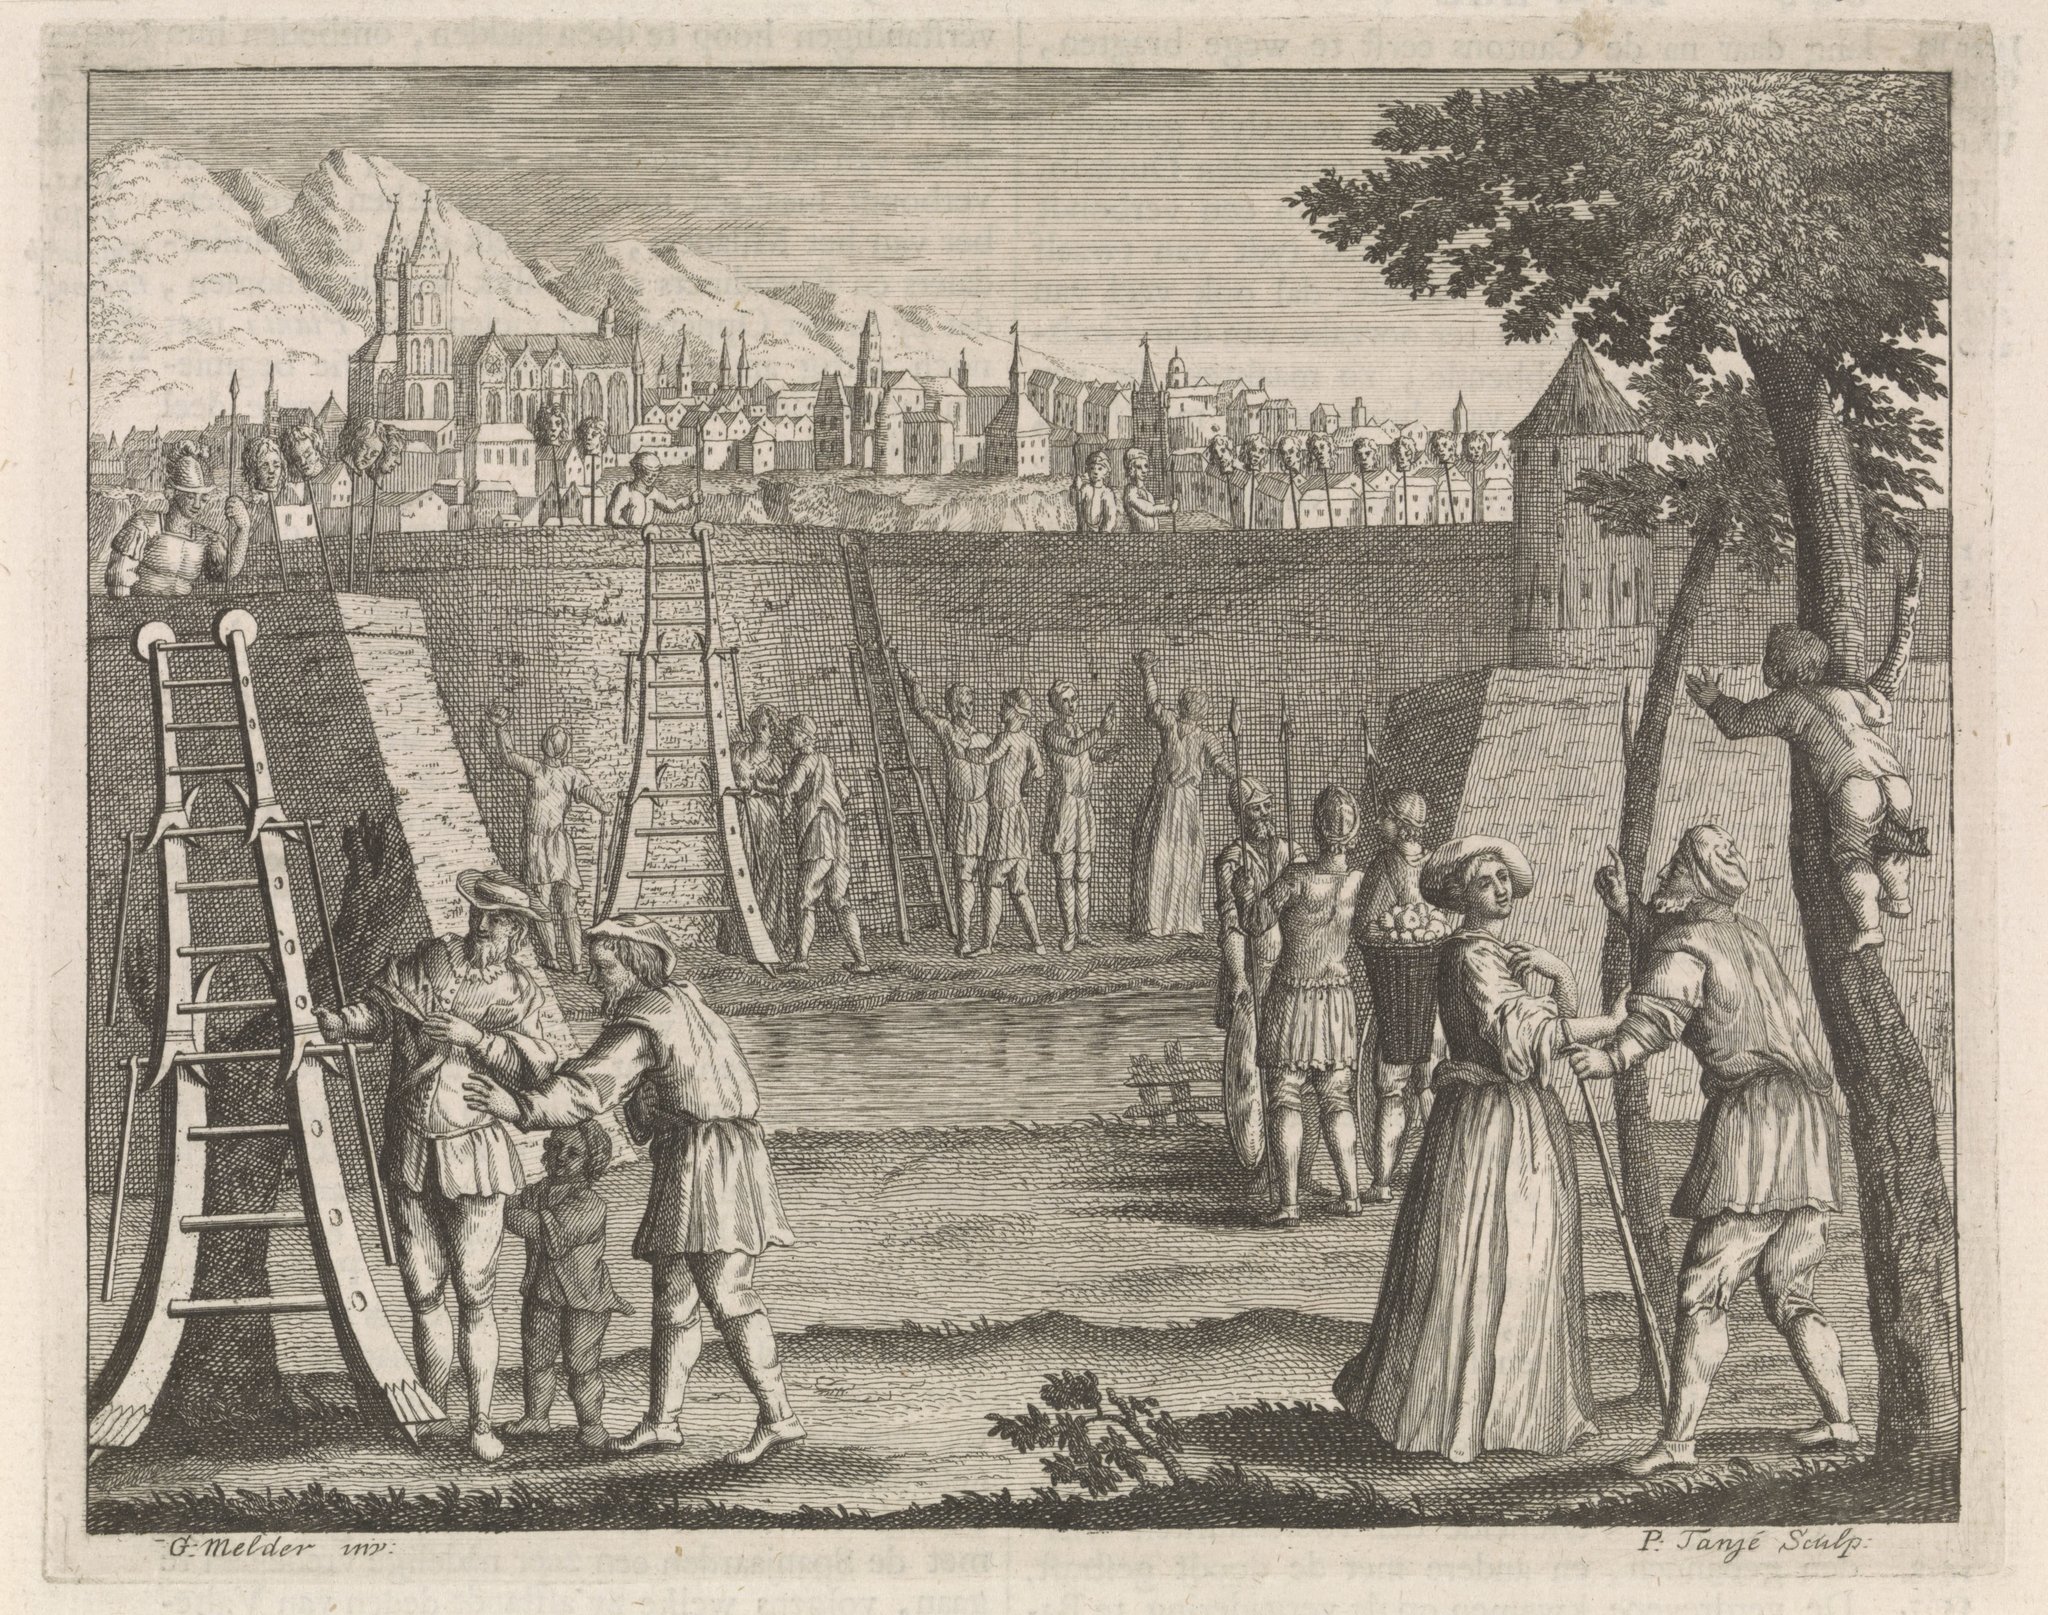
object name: print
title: Belegering van een stad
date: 1716-1761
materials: paper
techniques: engraving, etching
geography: amsterdam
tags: city-walls, ladder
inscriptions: collector's mark: Lugt 2228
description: Burgers en soldaten staan buiten de muren van een stad en richten ladders op. Op de muren staan staken met de hoofden van mensen.